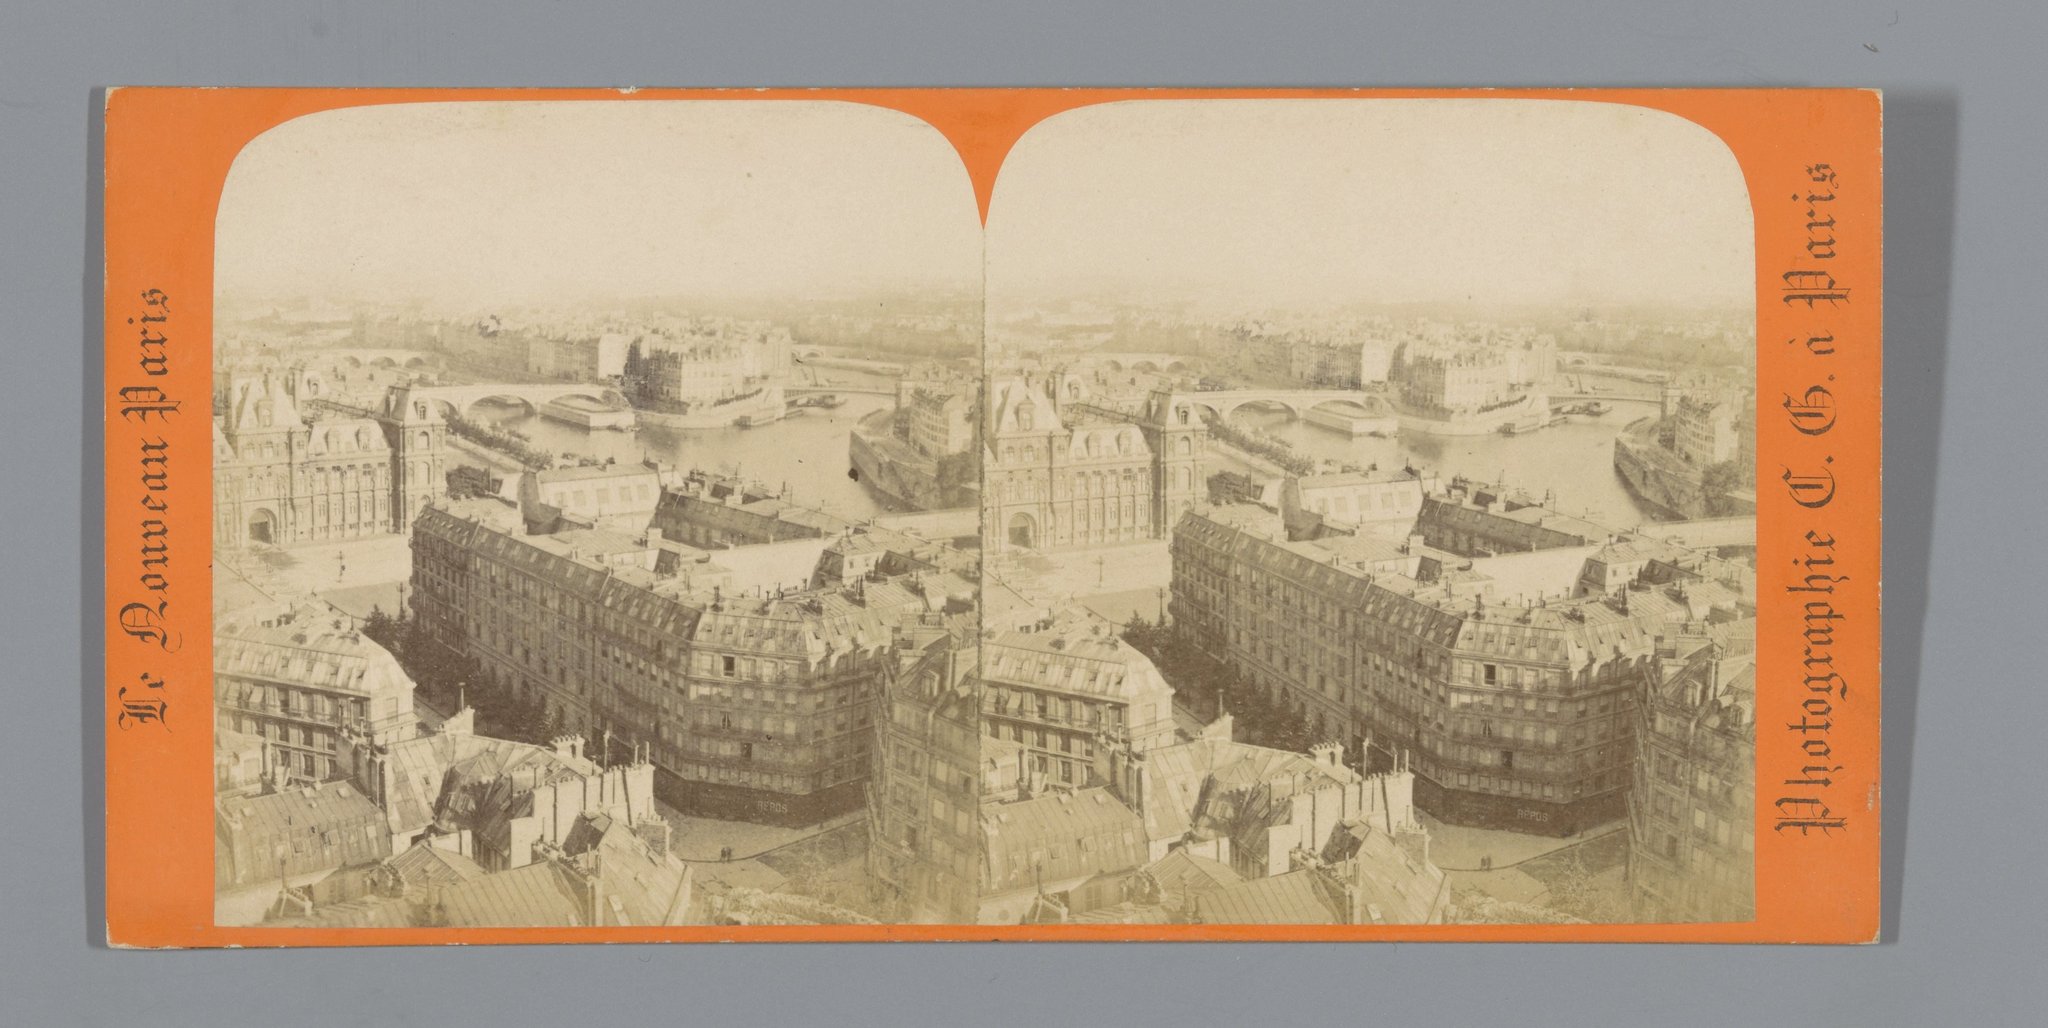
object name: stereograph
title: Le Nouveau Paris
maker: charles gérard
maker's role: fotograaf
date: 1860-1870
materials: cardboard, photographic support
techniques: albumen print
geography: paris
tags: city-view in general; 'veduta', paris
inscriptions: inscription: ‘Panorama de Paris’, inscription: ‘Photographie C. G. à Paris.’